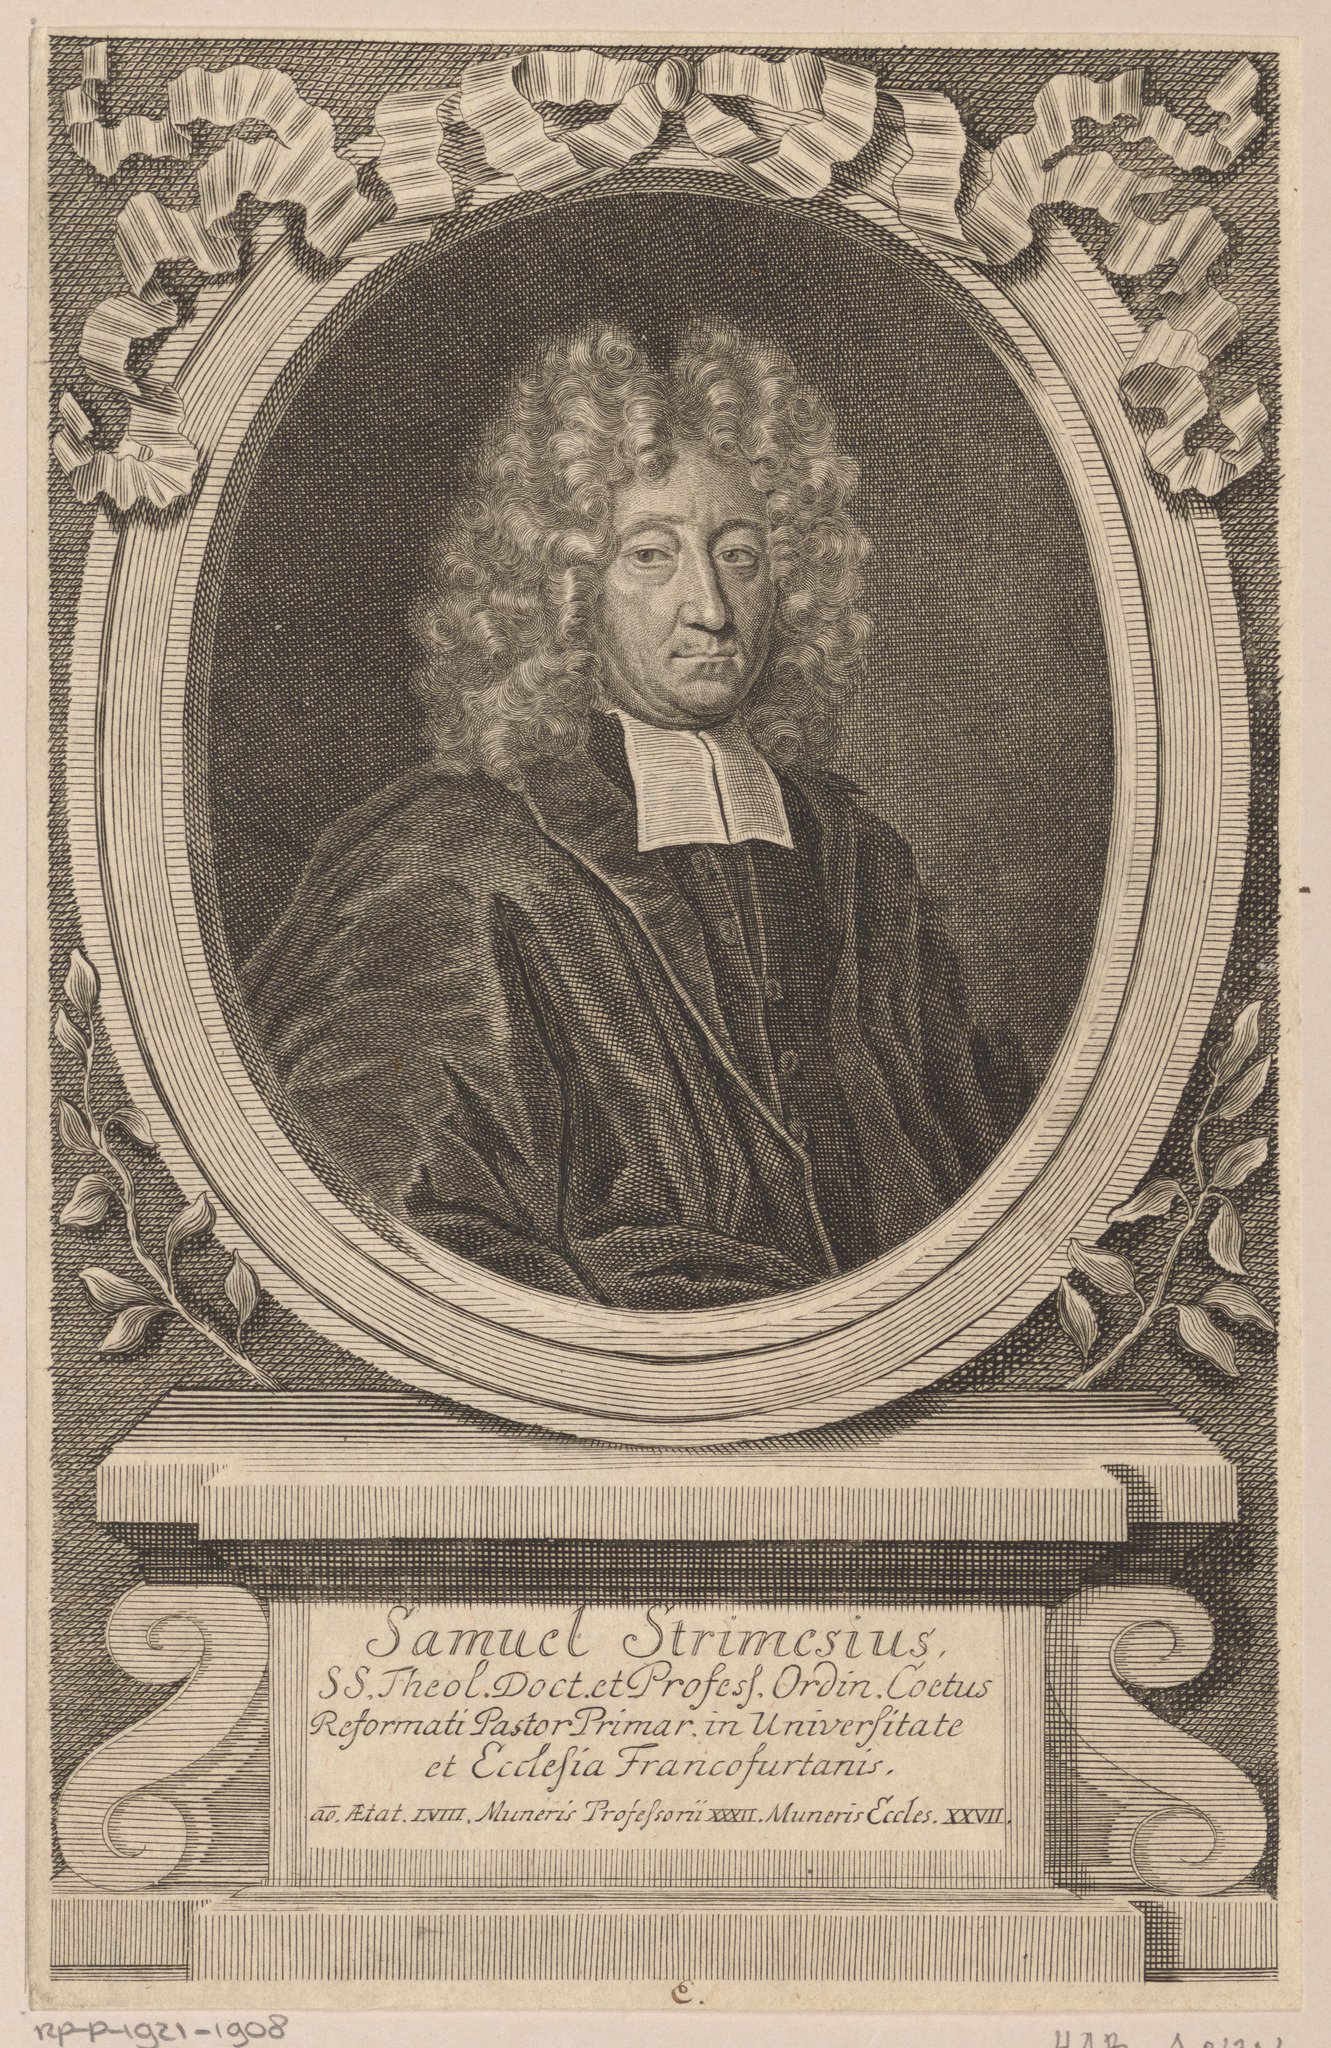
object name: print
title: Portret van Samuel Strimesius op 58-jarige leeftijd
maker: martin bernigeroth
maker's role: print maker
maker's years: 1670-1733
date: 1706-1707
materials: paper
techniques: engraving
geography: germany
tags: theologian, historical persons, professor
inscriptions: collector's mark: Lugt 2233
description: Prent mogelijk uit: Beckmann, Johann Christoph. Notitia Universitatis Francofurtanae (...). Frankfurt an der Oder: erven Jeremias Schrey en Johann Hartmann, 1707, p. 58